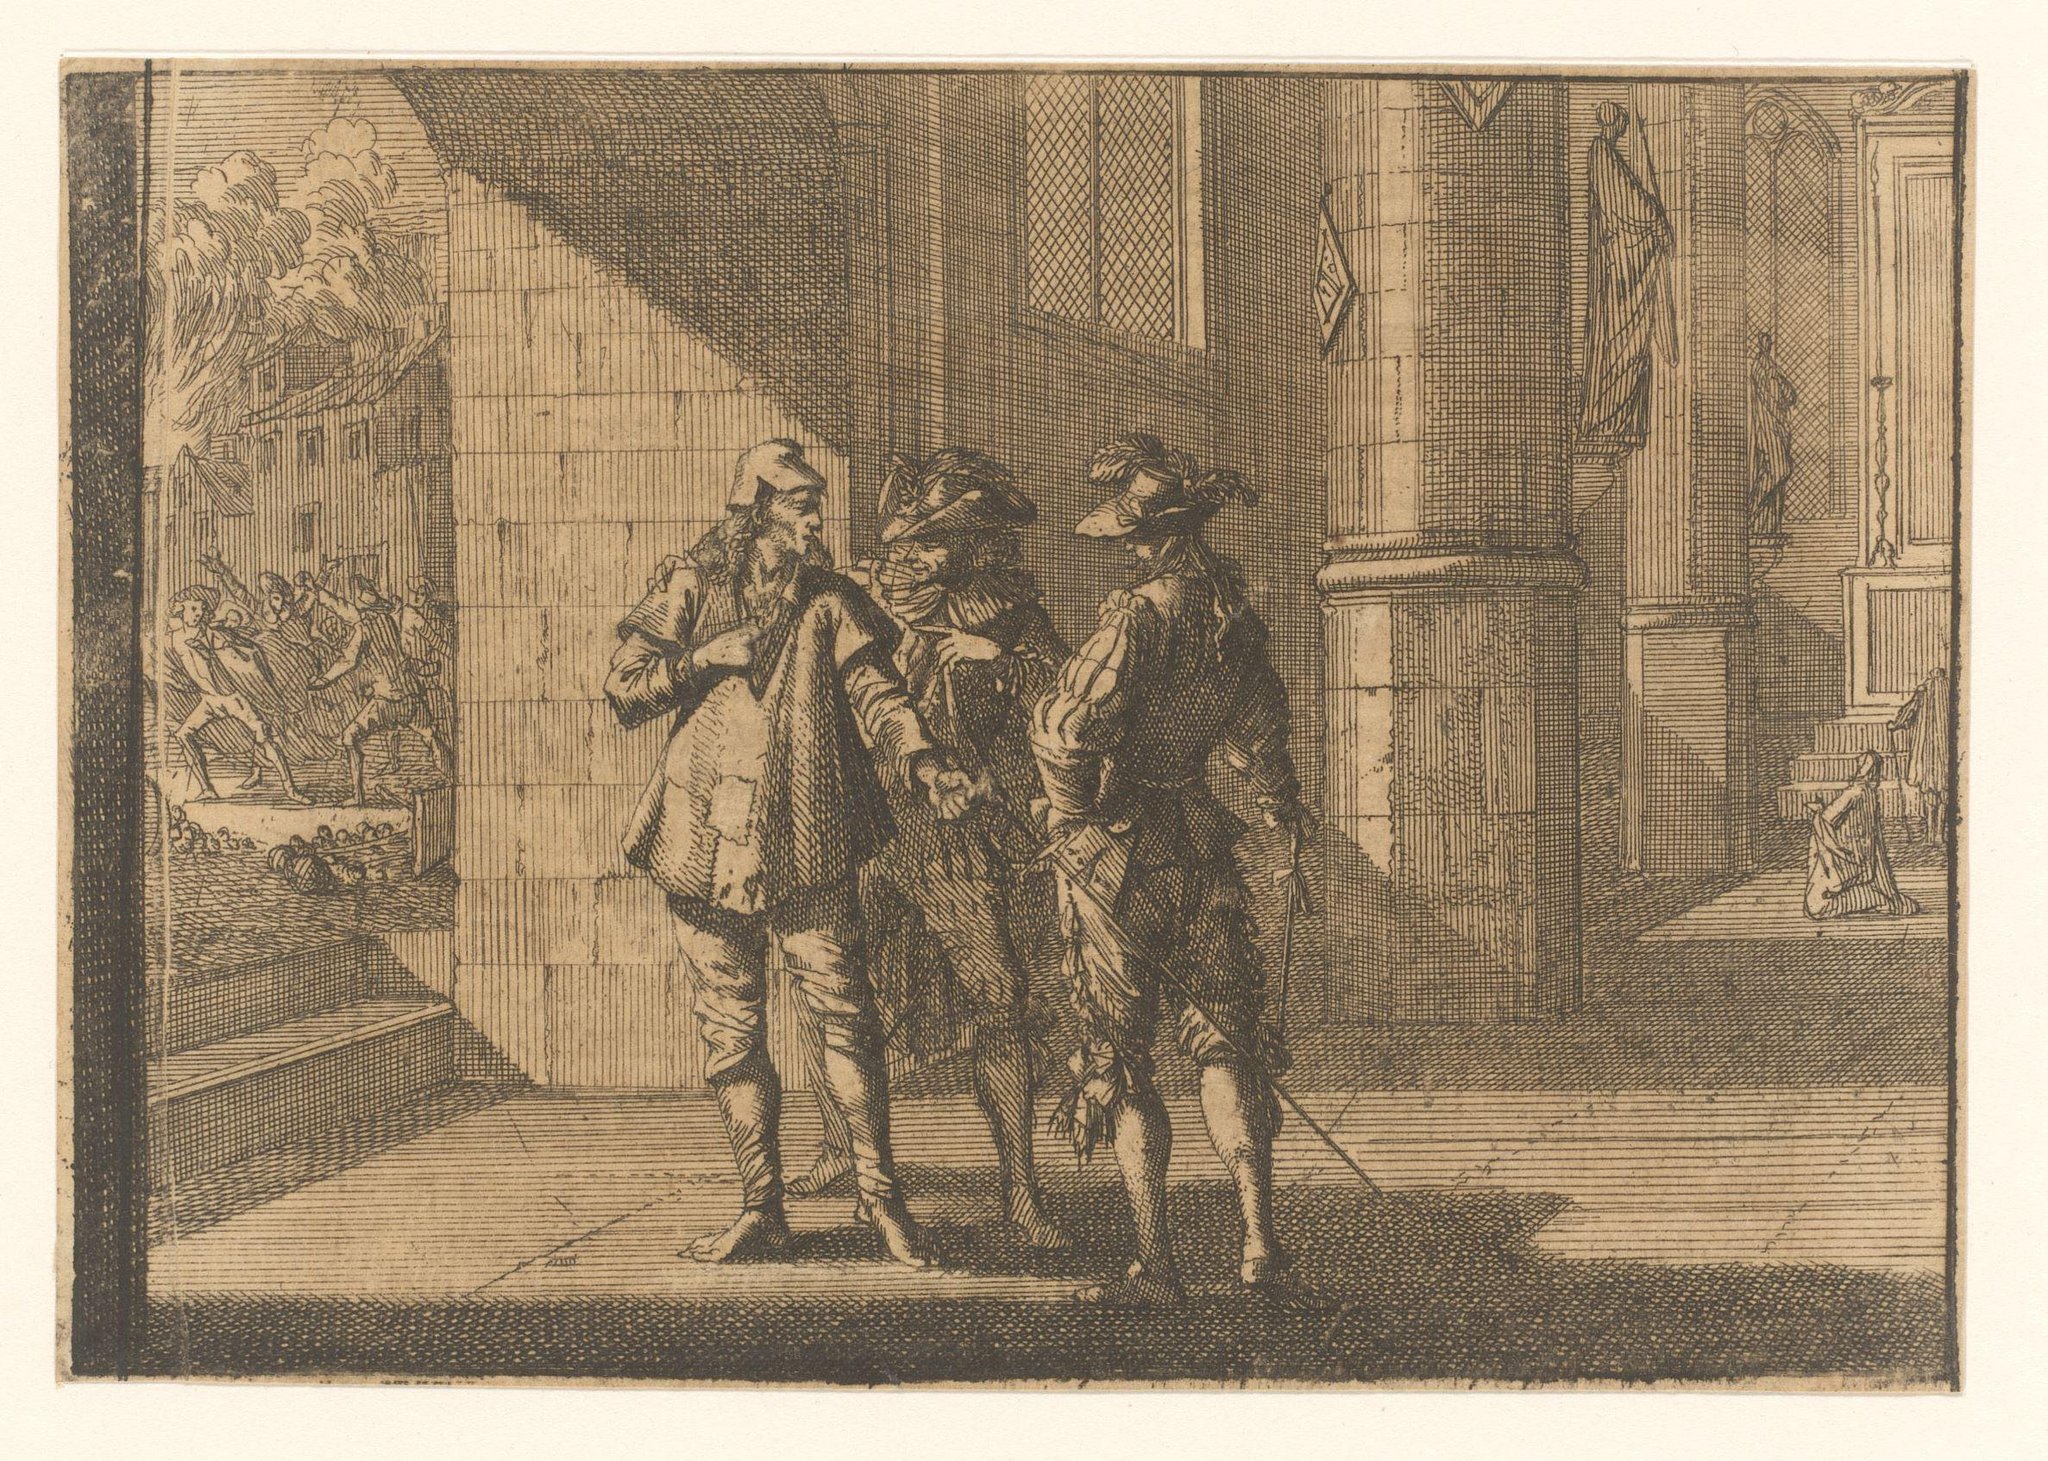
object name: book illustration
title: Masaniello praat met twee edellieden in een kerk, 1647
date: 1701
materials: paper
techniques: engraving, etching, letterpress printing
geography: frankfurt am main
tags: naples, on fire, ablaze, interior of church, revolution, revolt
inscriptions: collector's mark: Lugt 2228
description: Buiten een menigte op straat en brandende huizen. Mogelijk het moment van zijn arrestatie in de Santa Maria del Carmine, 16 juli 1647.